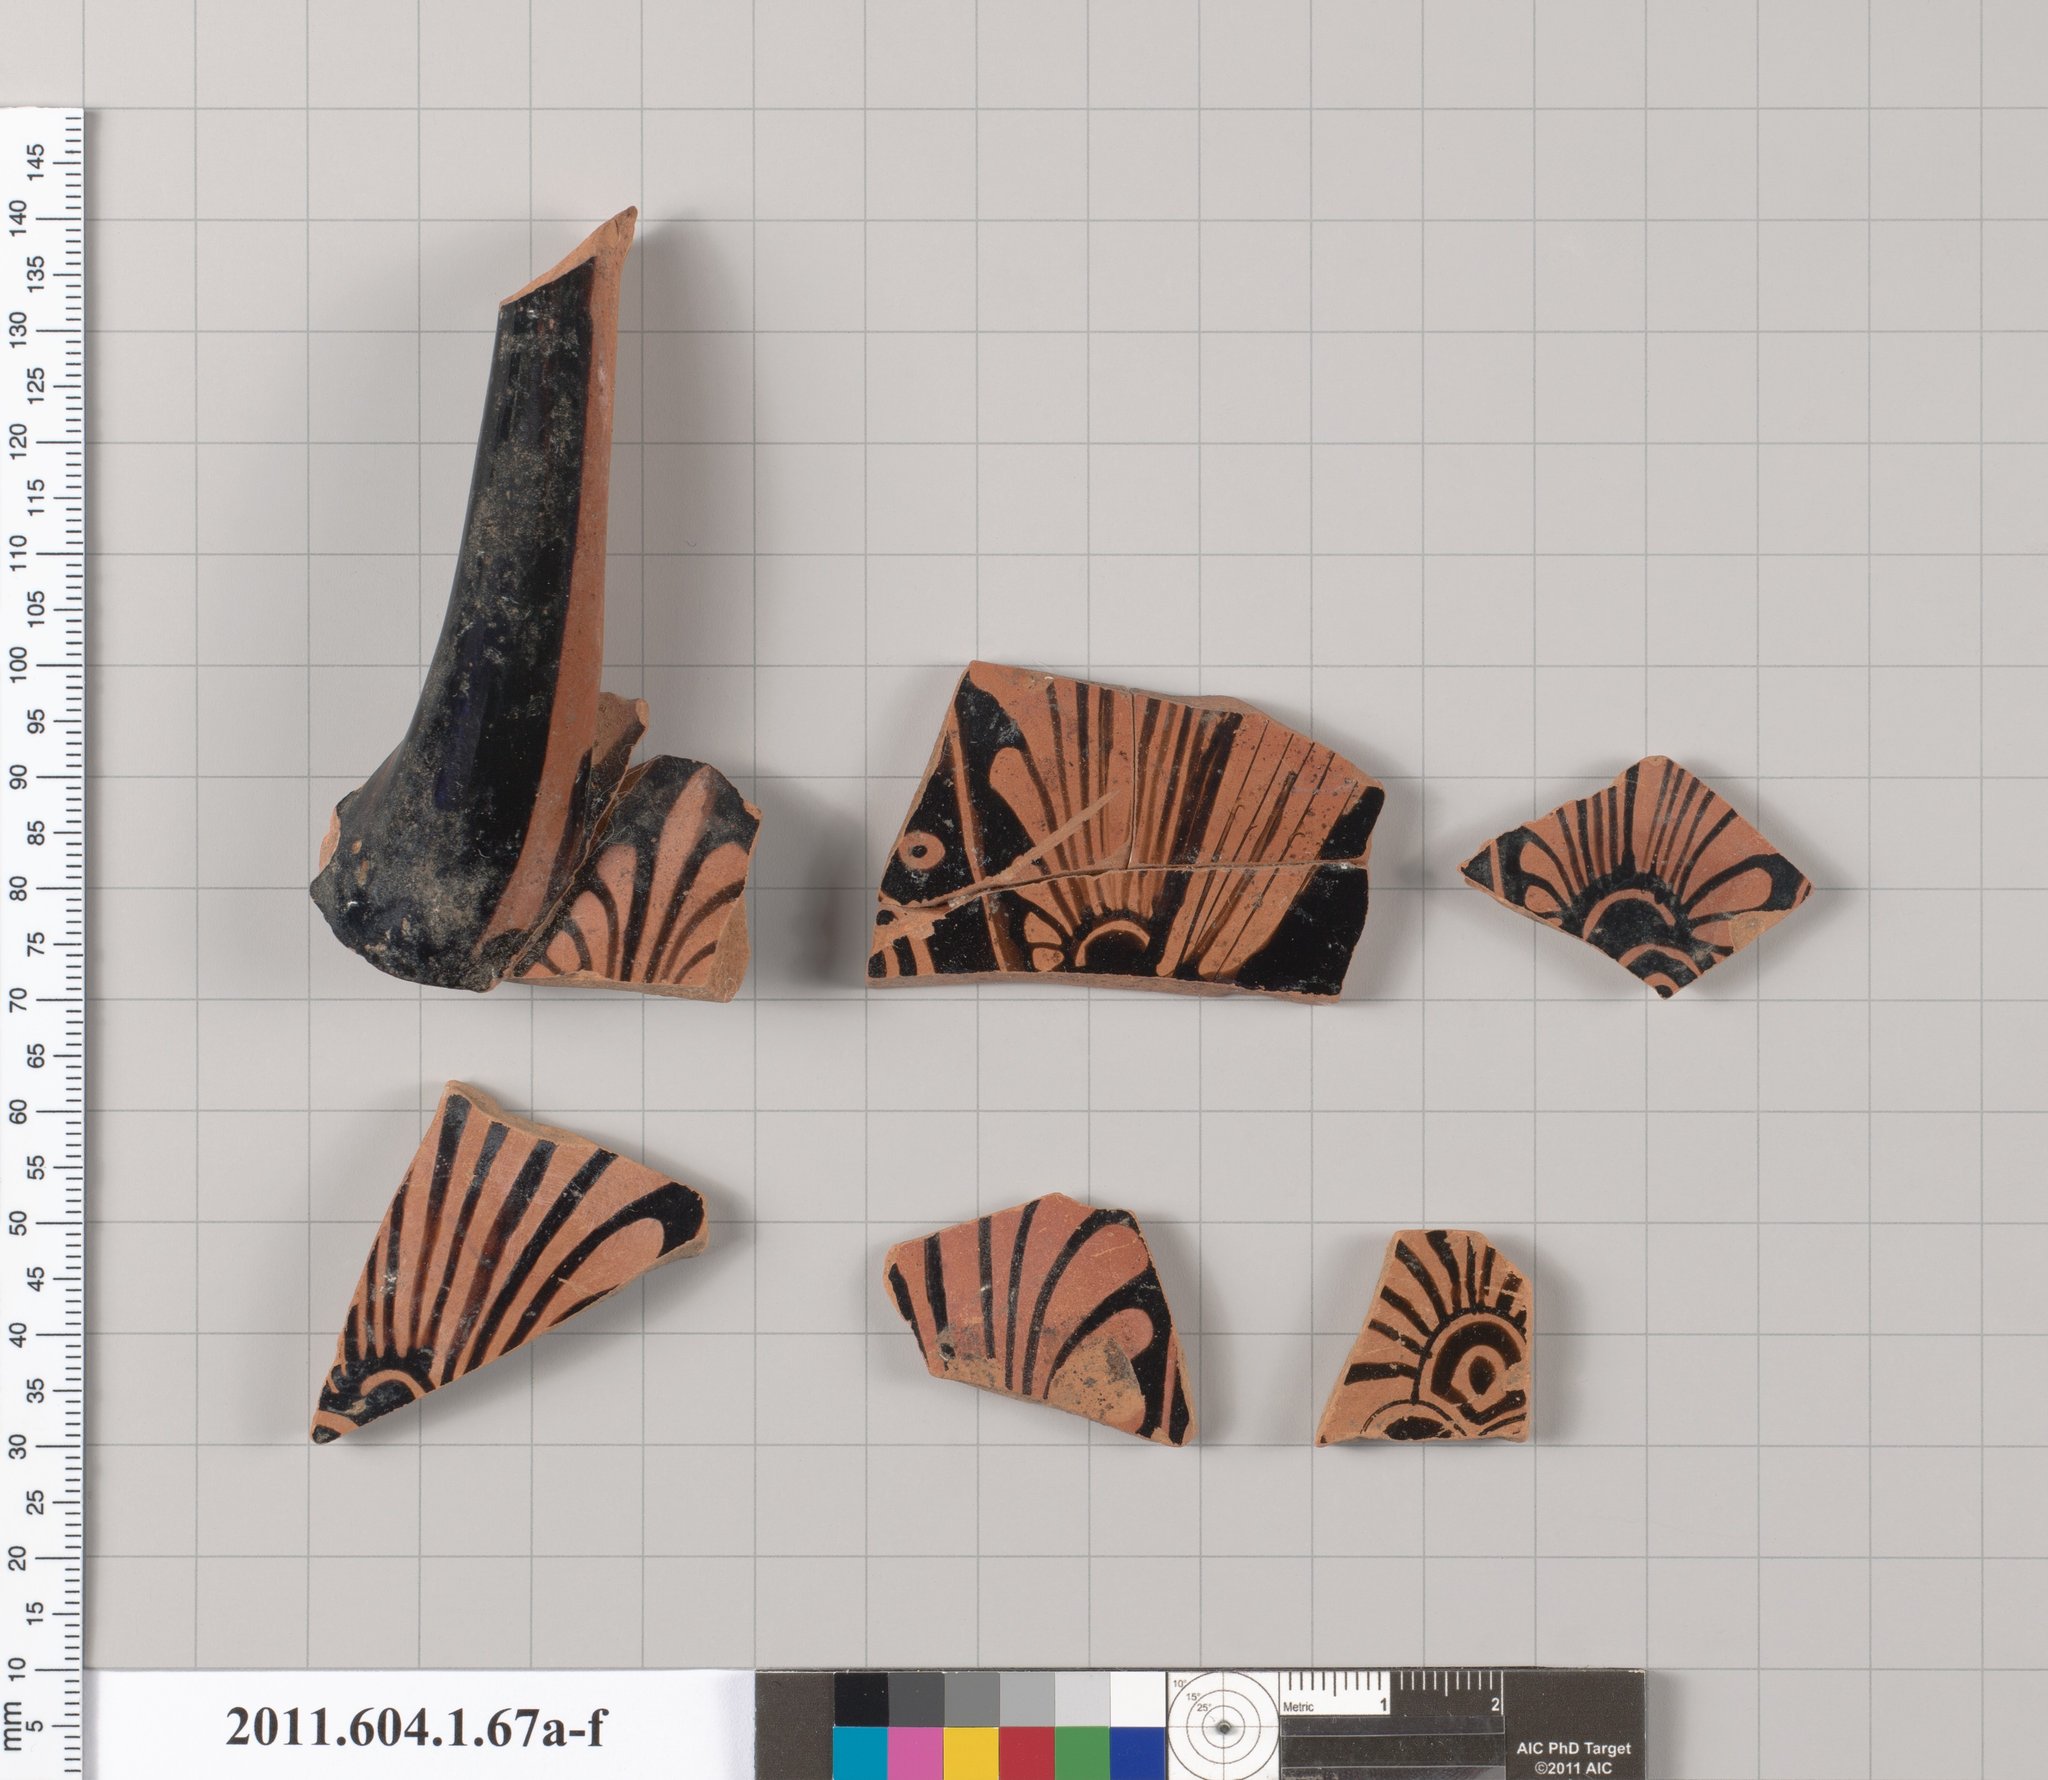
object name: kylix fragment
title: Terracotta fragments of a kylix (drinking cup)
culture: greek, attic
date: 467-435 BCE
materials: terracotta